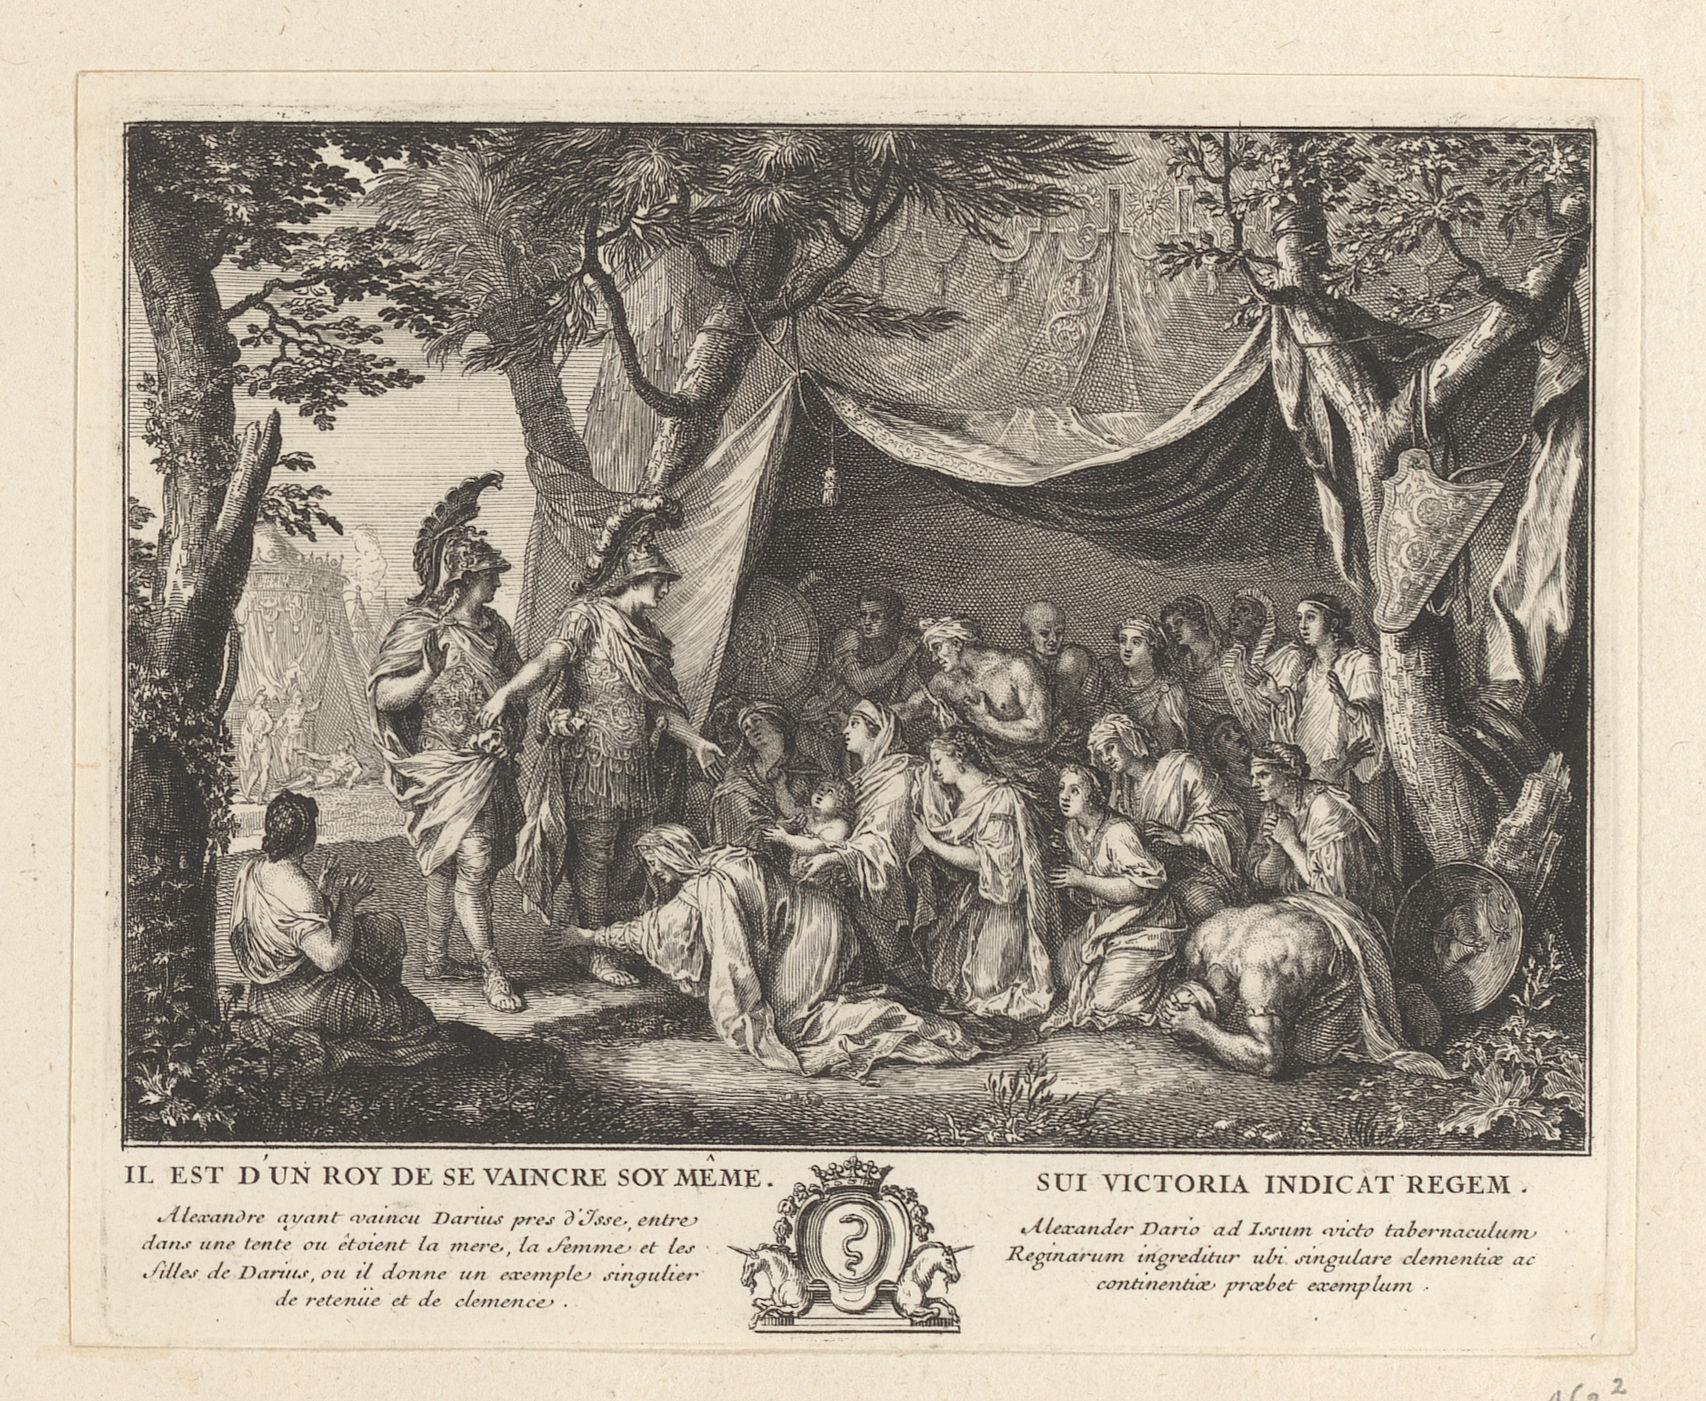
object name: print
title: Alexander de Grote bij de tent van Darius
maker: sébastien leclerc (i)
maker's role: print maker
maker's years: 1637-1714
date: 1696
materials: paper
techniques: engraving, etching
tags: historical persons, darius' family kneels before alexander, who requests sisigambis, darius' mother, to rise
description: Onder de voorstelling het wapenschild van Edouard Colbert de Villacerf. Prent maakt deel uit van een album.